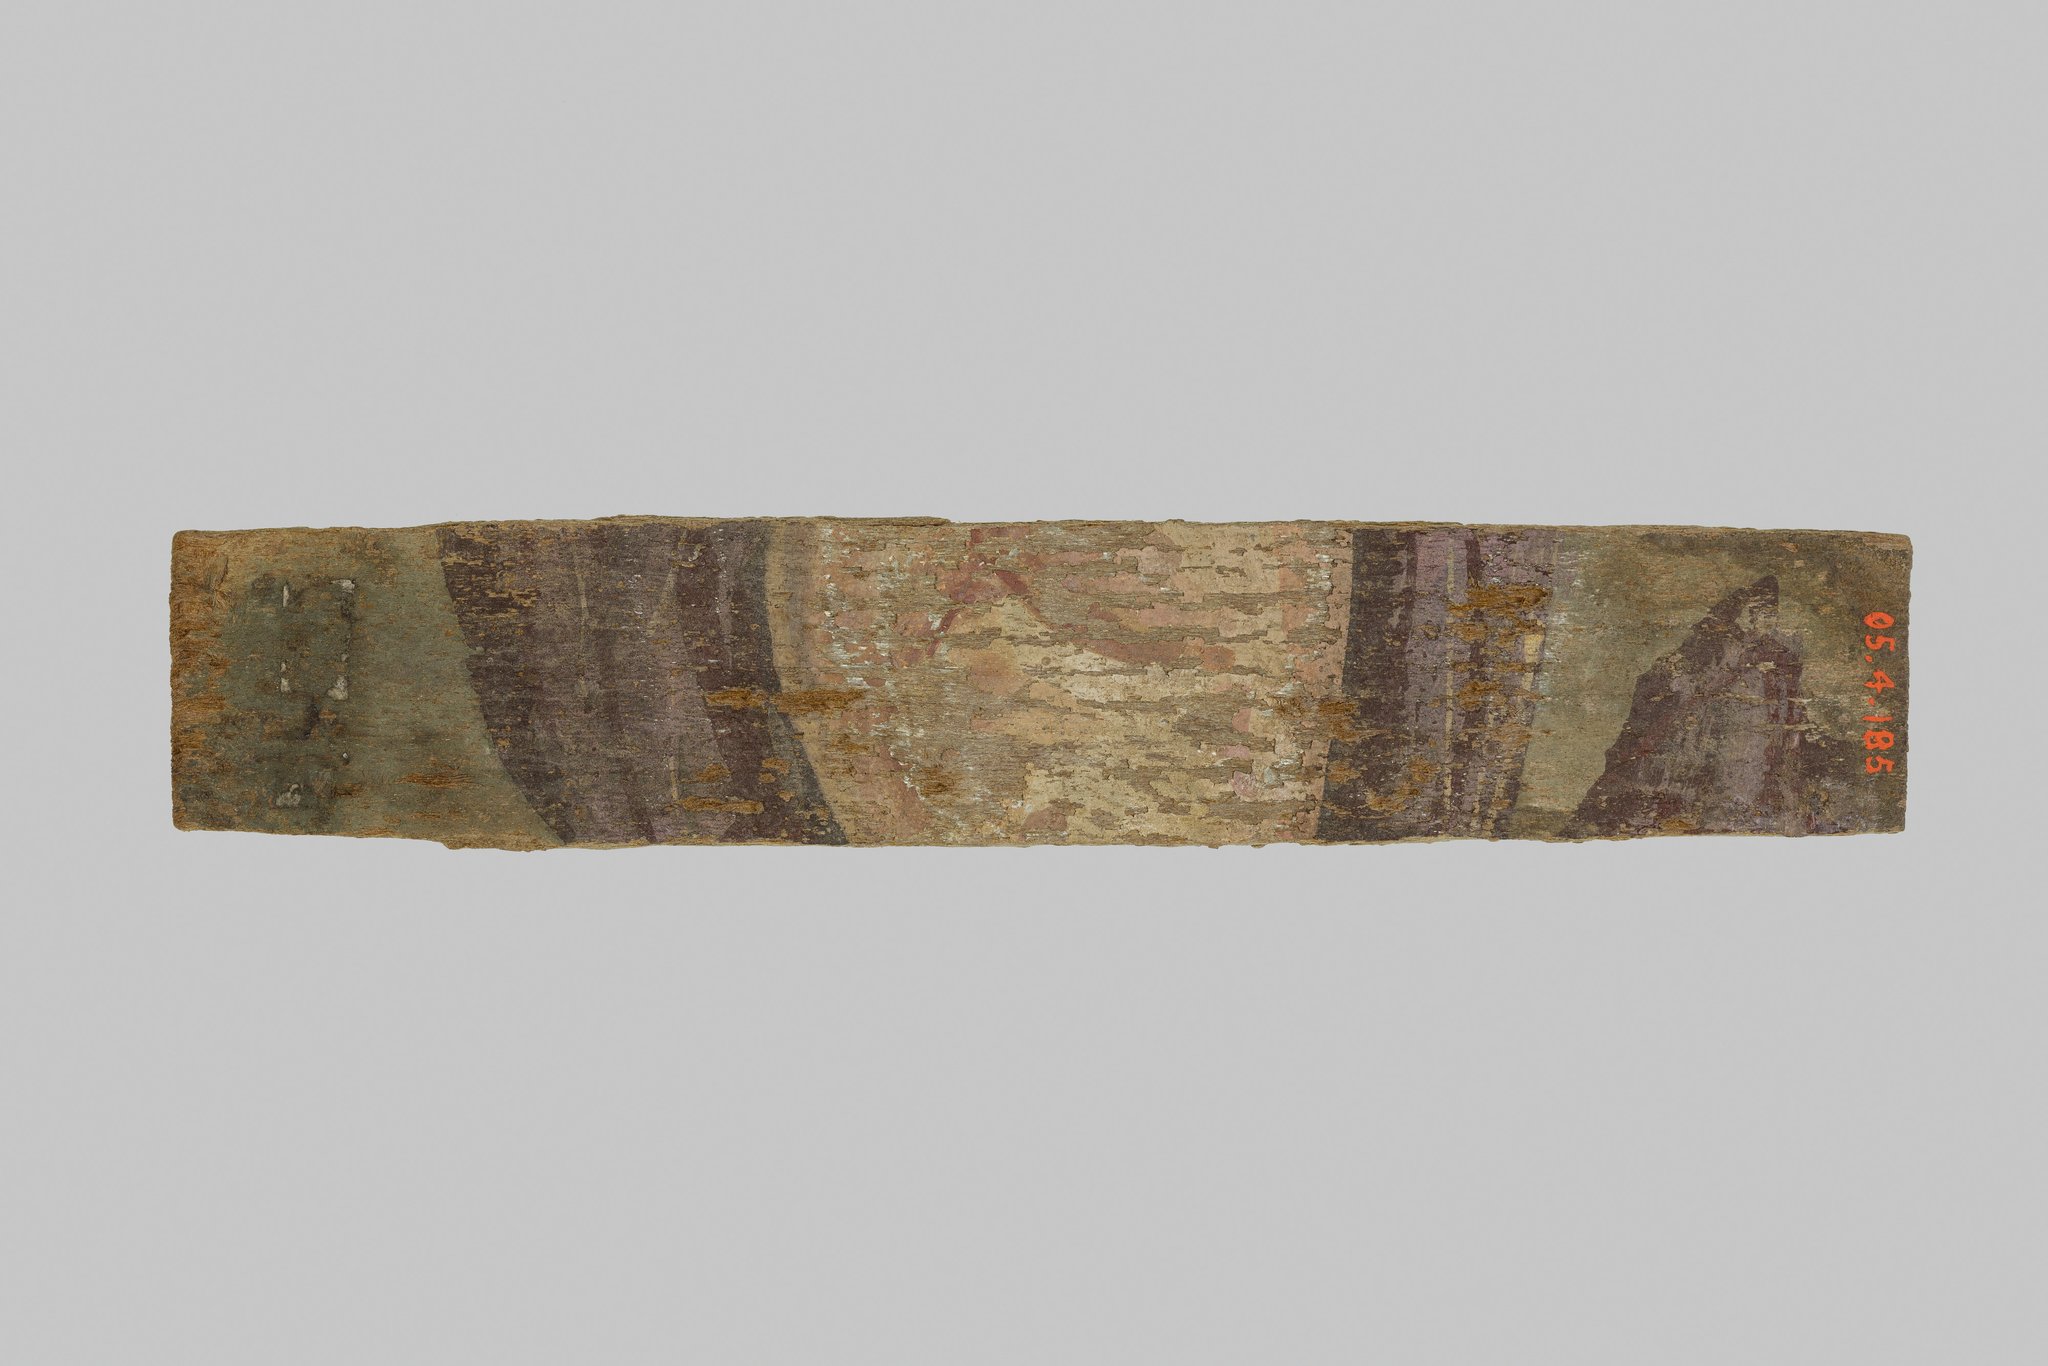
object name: mummy label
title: Fragment of a mummy label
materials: pigment, wood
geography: egypt